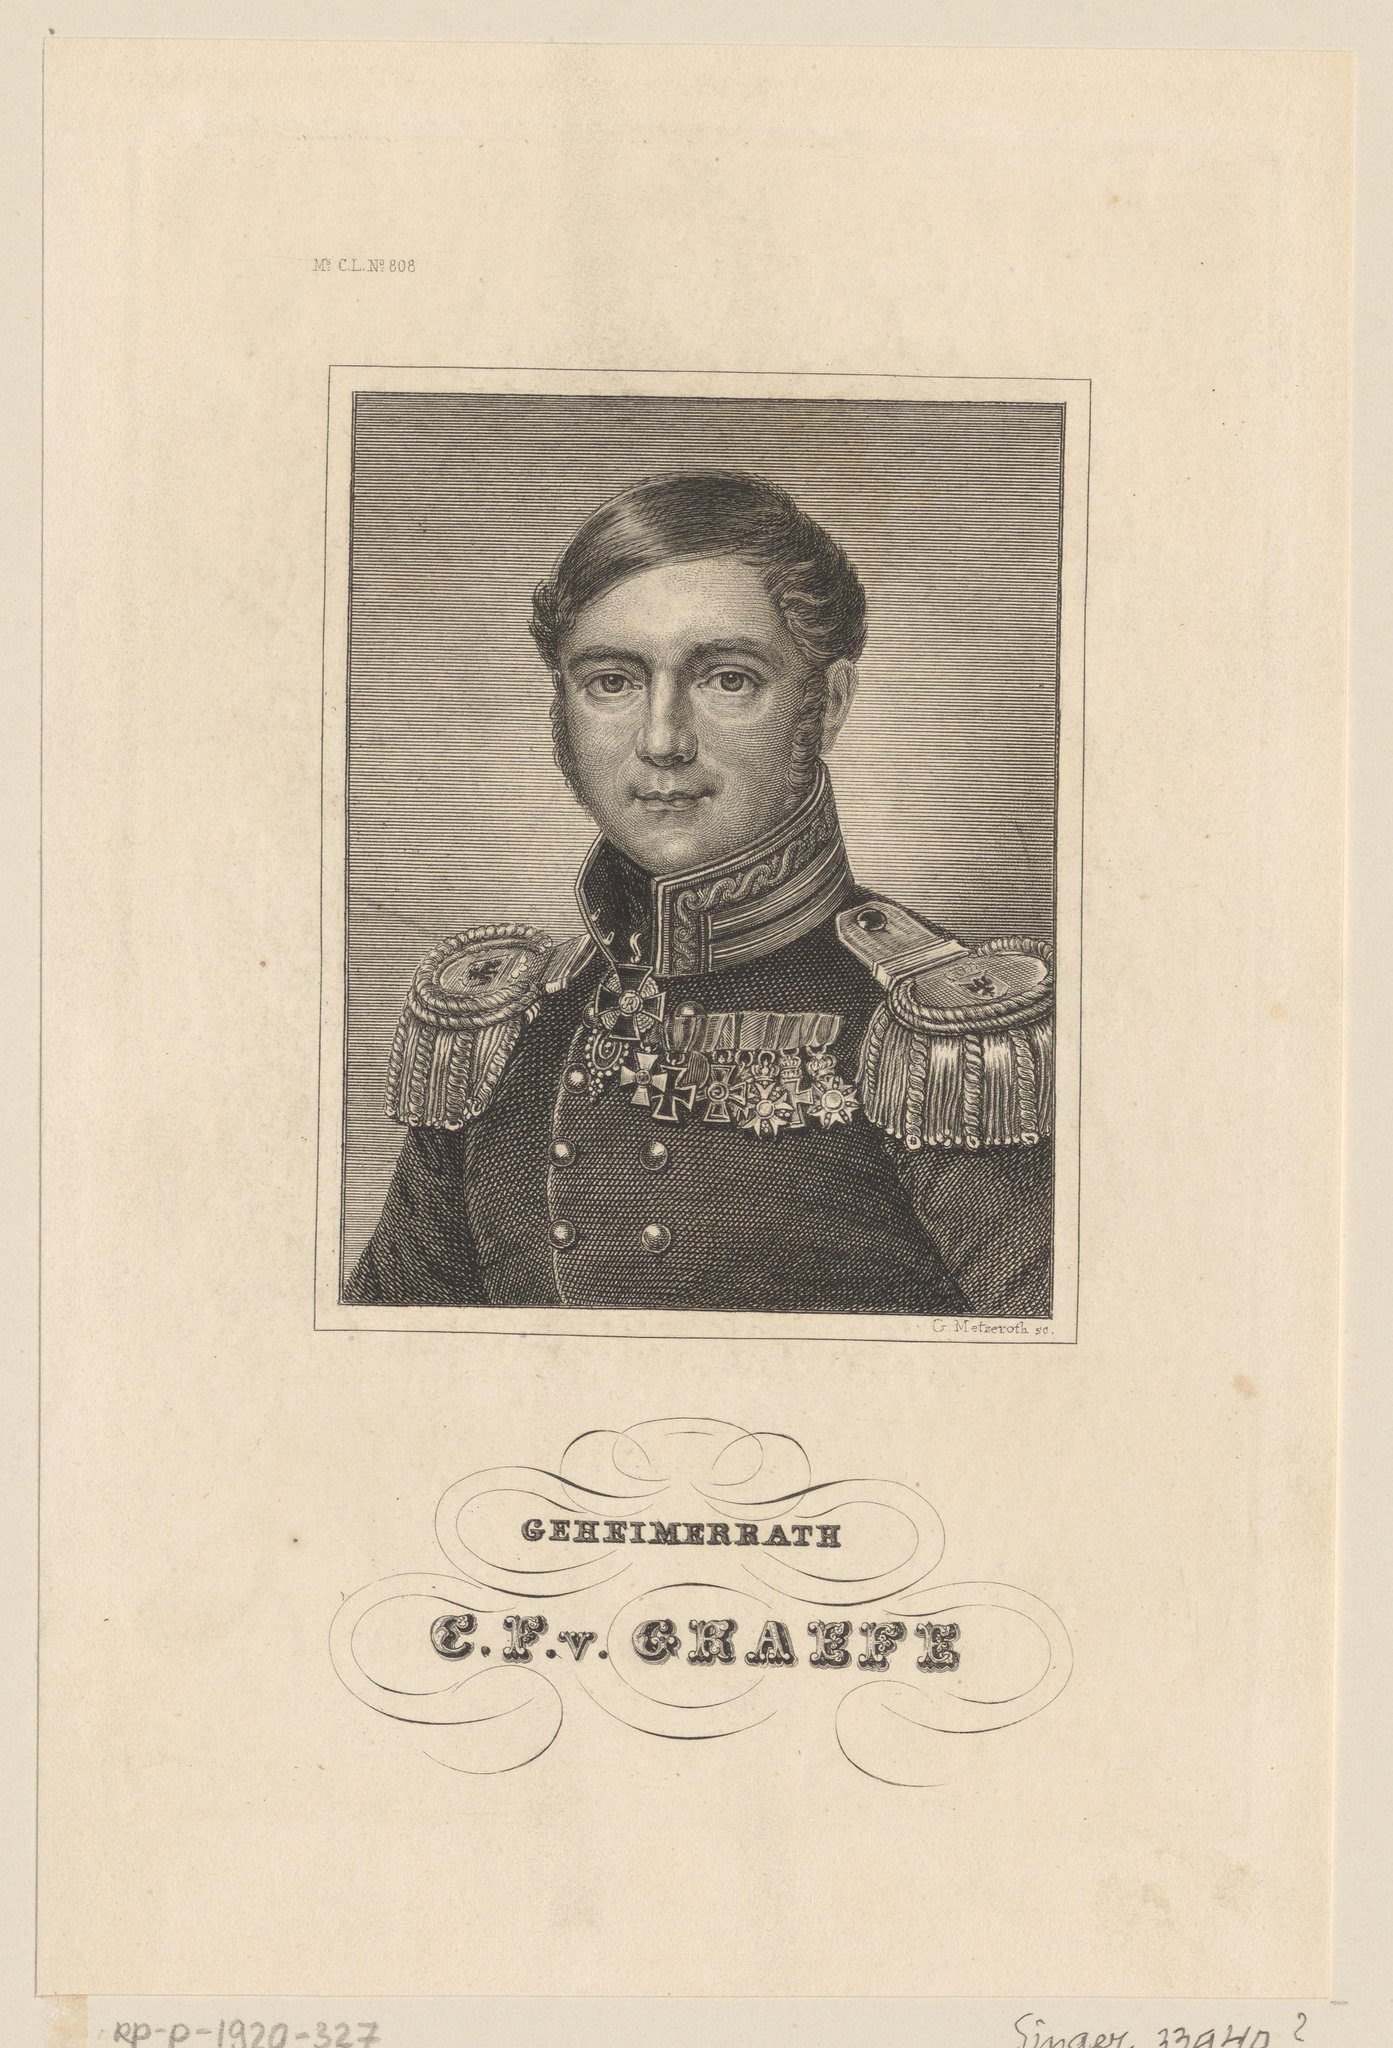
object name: print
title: Portret van Karl Ferdinand von Gräfe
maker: g. metzeroth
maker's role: print maker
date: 1839-1855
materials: paper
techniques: engraving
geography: hildburghausen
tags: karl ferdinand von gräfe, historical persons, physician, doctor (+ portrait of scholar, scientist), professor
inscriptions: collector's mark: Lugt 2228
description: Prent uit: Meyers Konversations-Lexikon. Hildburghausen: Bibliographisches Insistut, 1839-1855.